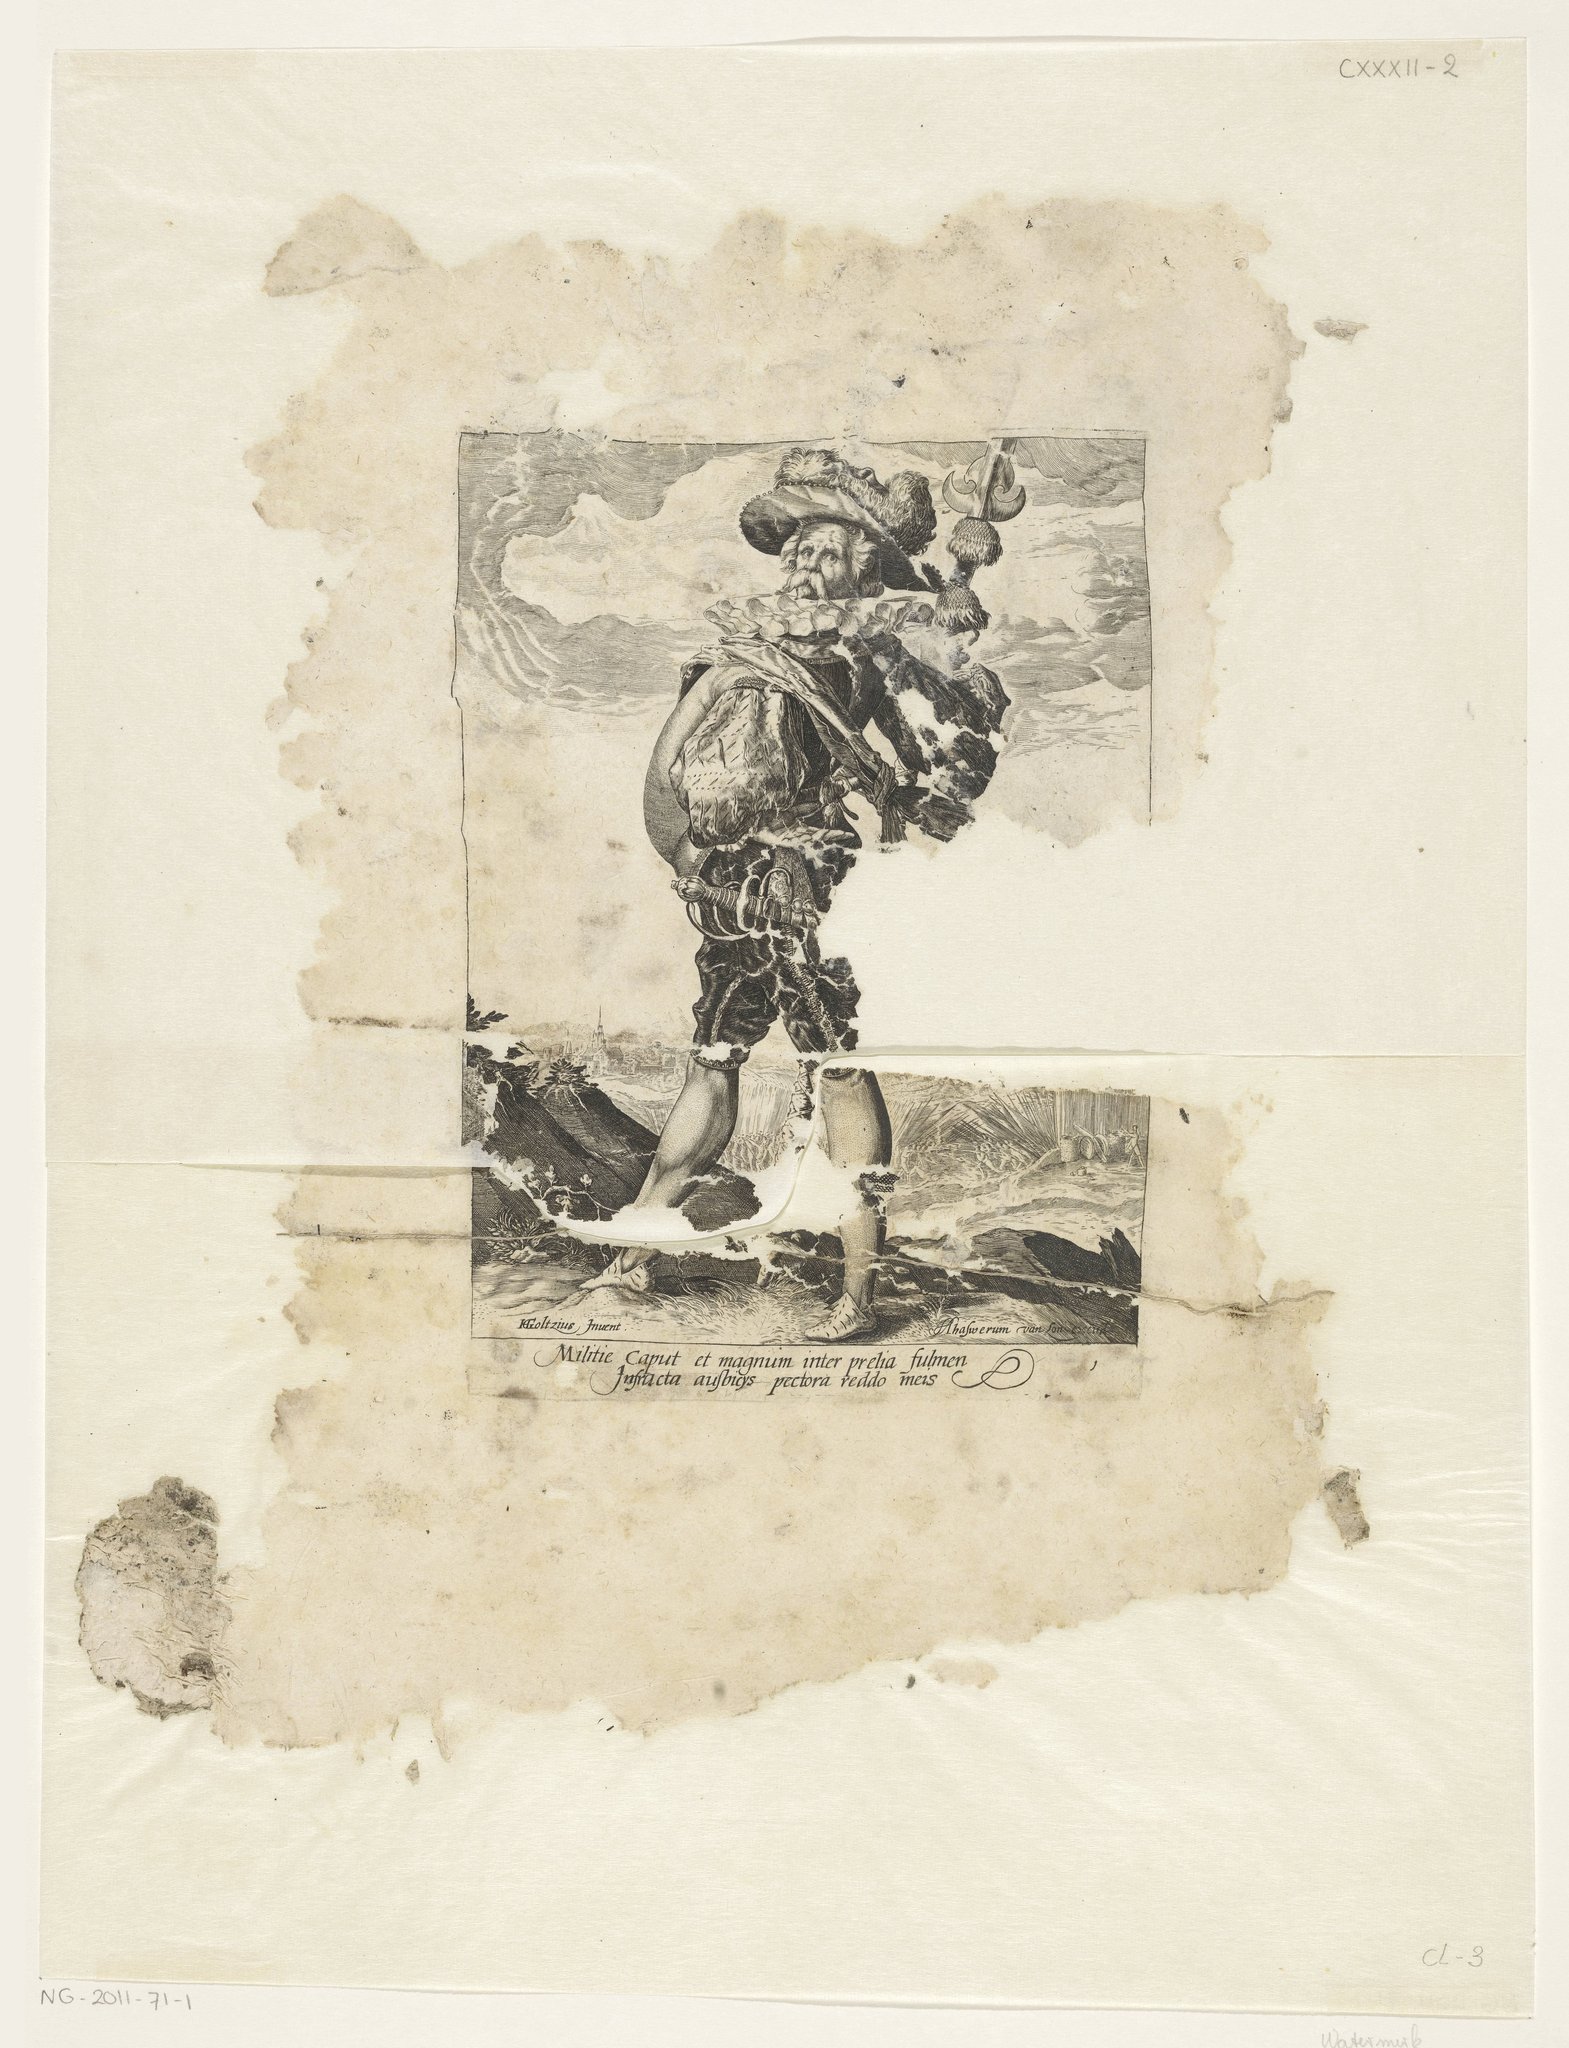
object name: print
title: Officieren en soldaten uit de lijfwacht van keizer Rudolf II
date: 1587-1596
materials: paper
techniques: engraving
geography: northern netherlands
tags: officer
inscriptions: watermark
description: De prenten in de Nova Zembla collectie zijn tijdens een expeditie van Willem Barendsz en Jacob van Heemskerk in 1596-1597 noodgedwongen in het winterkamp, het ‘Behouden Huis’, op het eiland achtergelaten. De prenten waren in één of meerdere stapels als handelswaar meegenomen vanuit Amsterdam. Bijna drie eeuwen later, in 1871, keerde de Noor Elling Carlsen terug naar Nova Zembla en vond daar de restanten van het ‘Behouden Huis, inclusief een groot deel van de inventaris. Een deel van de prenten, in de vorm van aaneengekoekte kluiten, werd toen ook teruggevonden. De papierkluiten waren soms op meerdere plekken gebroken. Tussen 1975-1979 zijn de prenten van elkaar gescheiden. Dit leverde in totaal ca. 1000 fragmenten van ca. 400 afdrukken van ca. 150 verschillende prenten op. Voor zover mogelijk zijn de fragmenten samengevoegd en zijn de prenten gereconstrueerd.